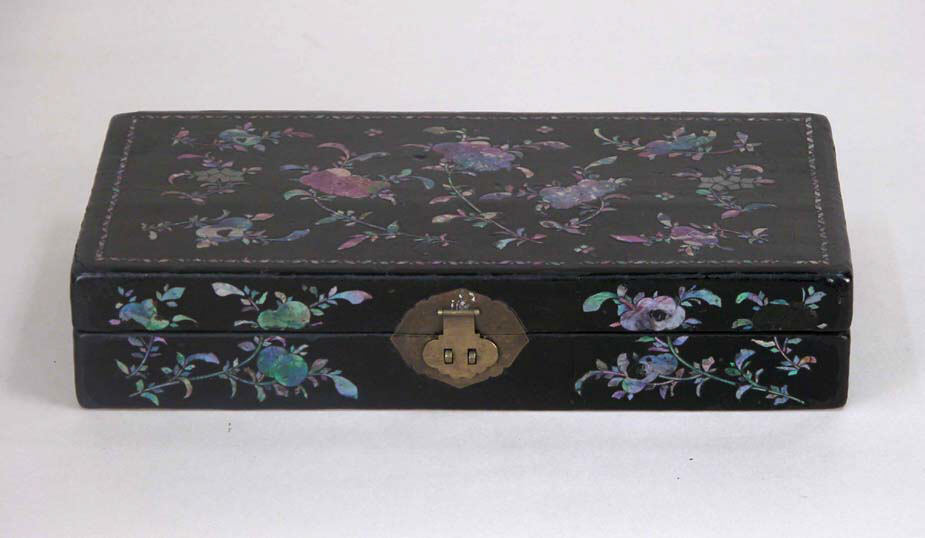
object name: box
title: Box with Lock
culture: chinese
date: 1801-1900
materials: lacquer